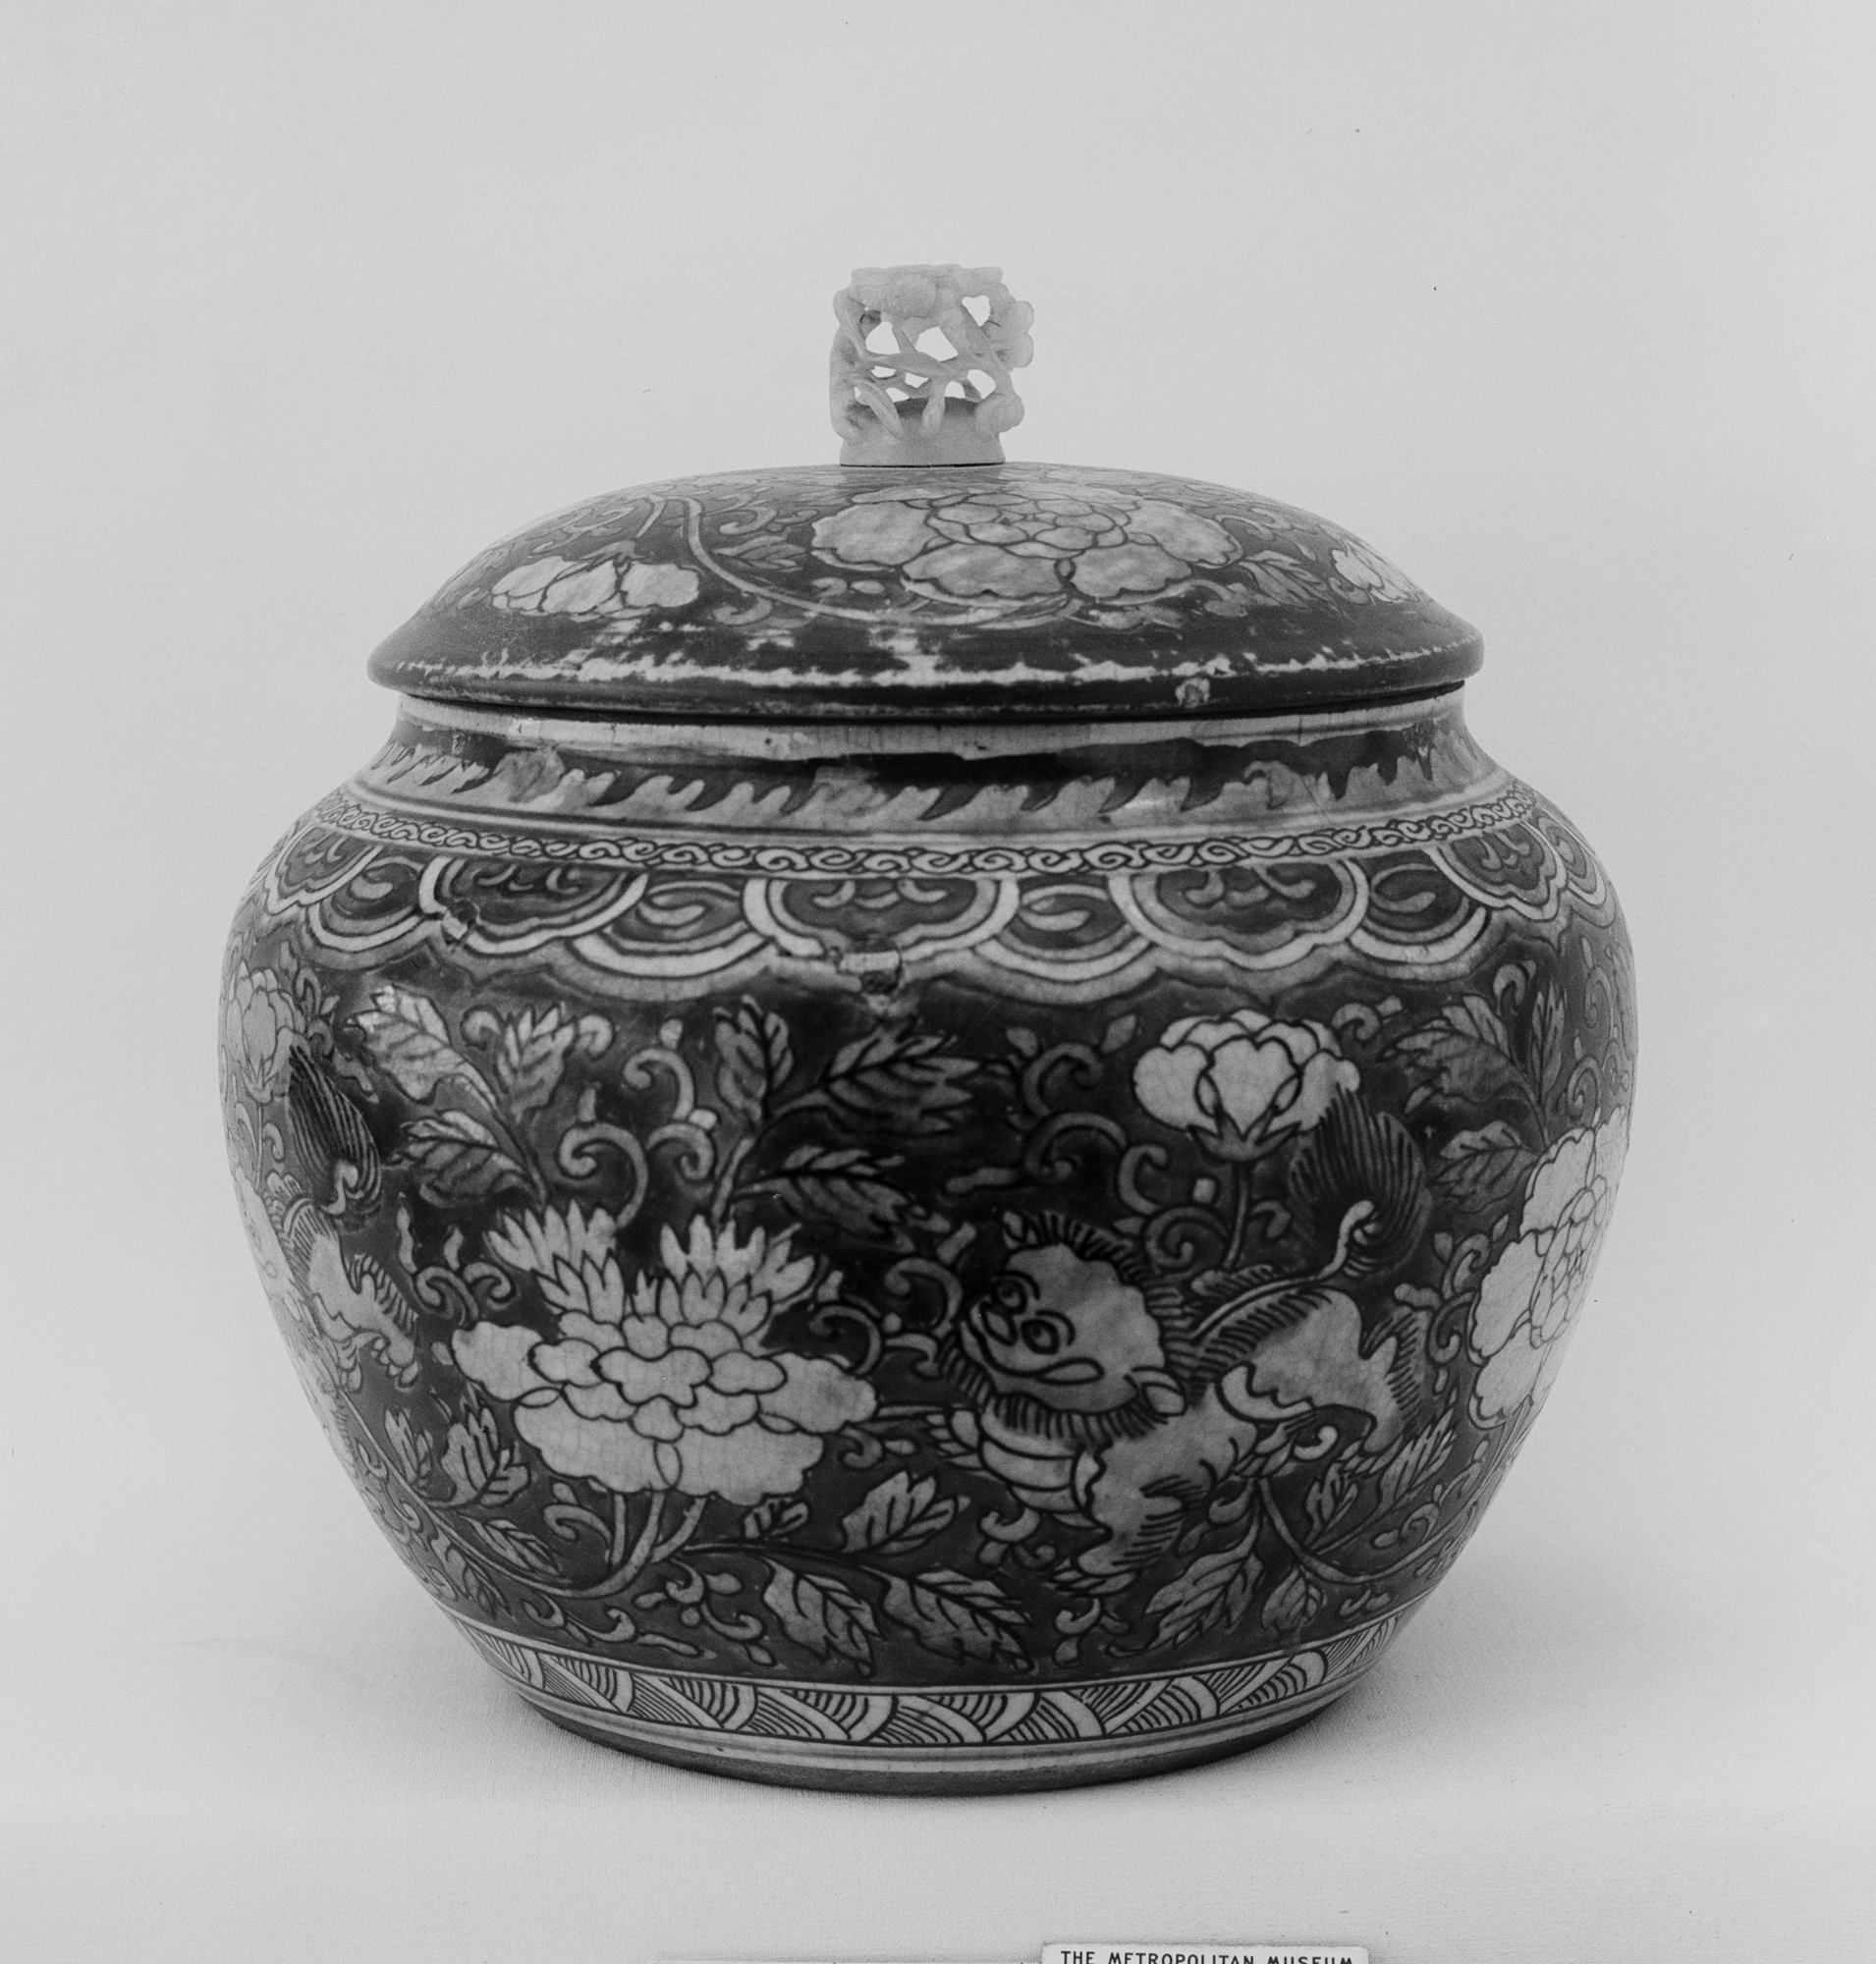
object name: covered jar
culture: japanese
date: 1701-1800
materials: clay, enamel, glaze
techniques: polychrome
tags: animals,flowers